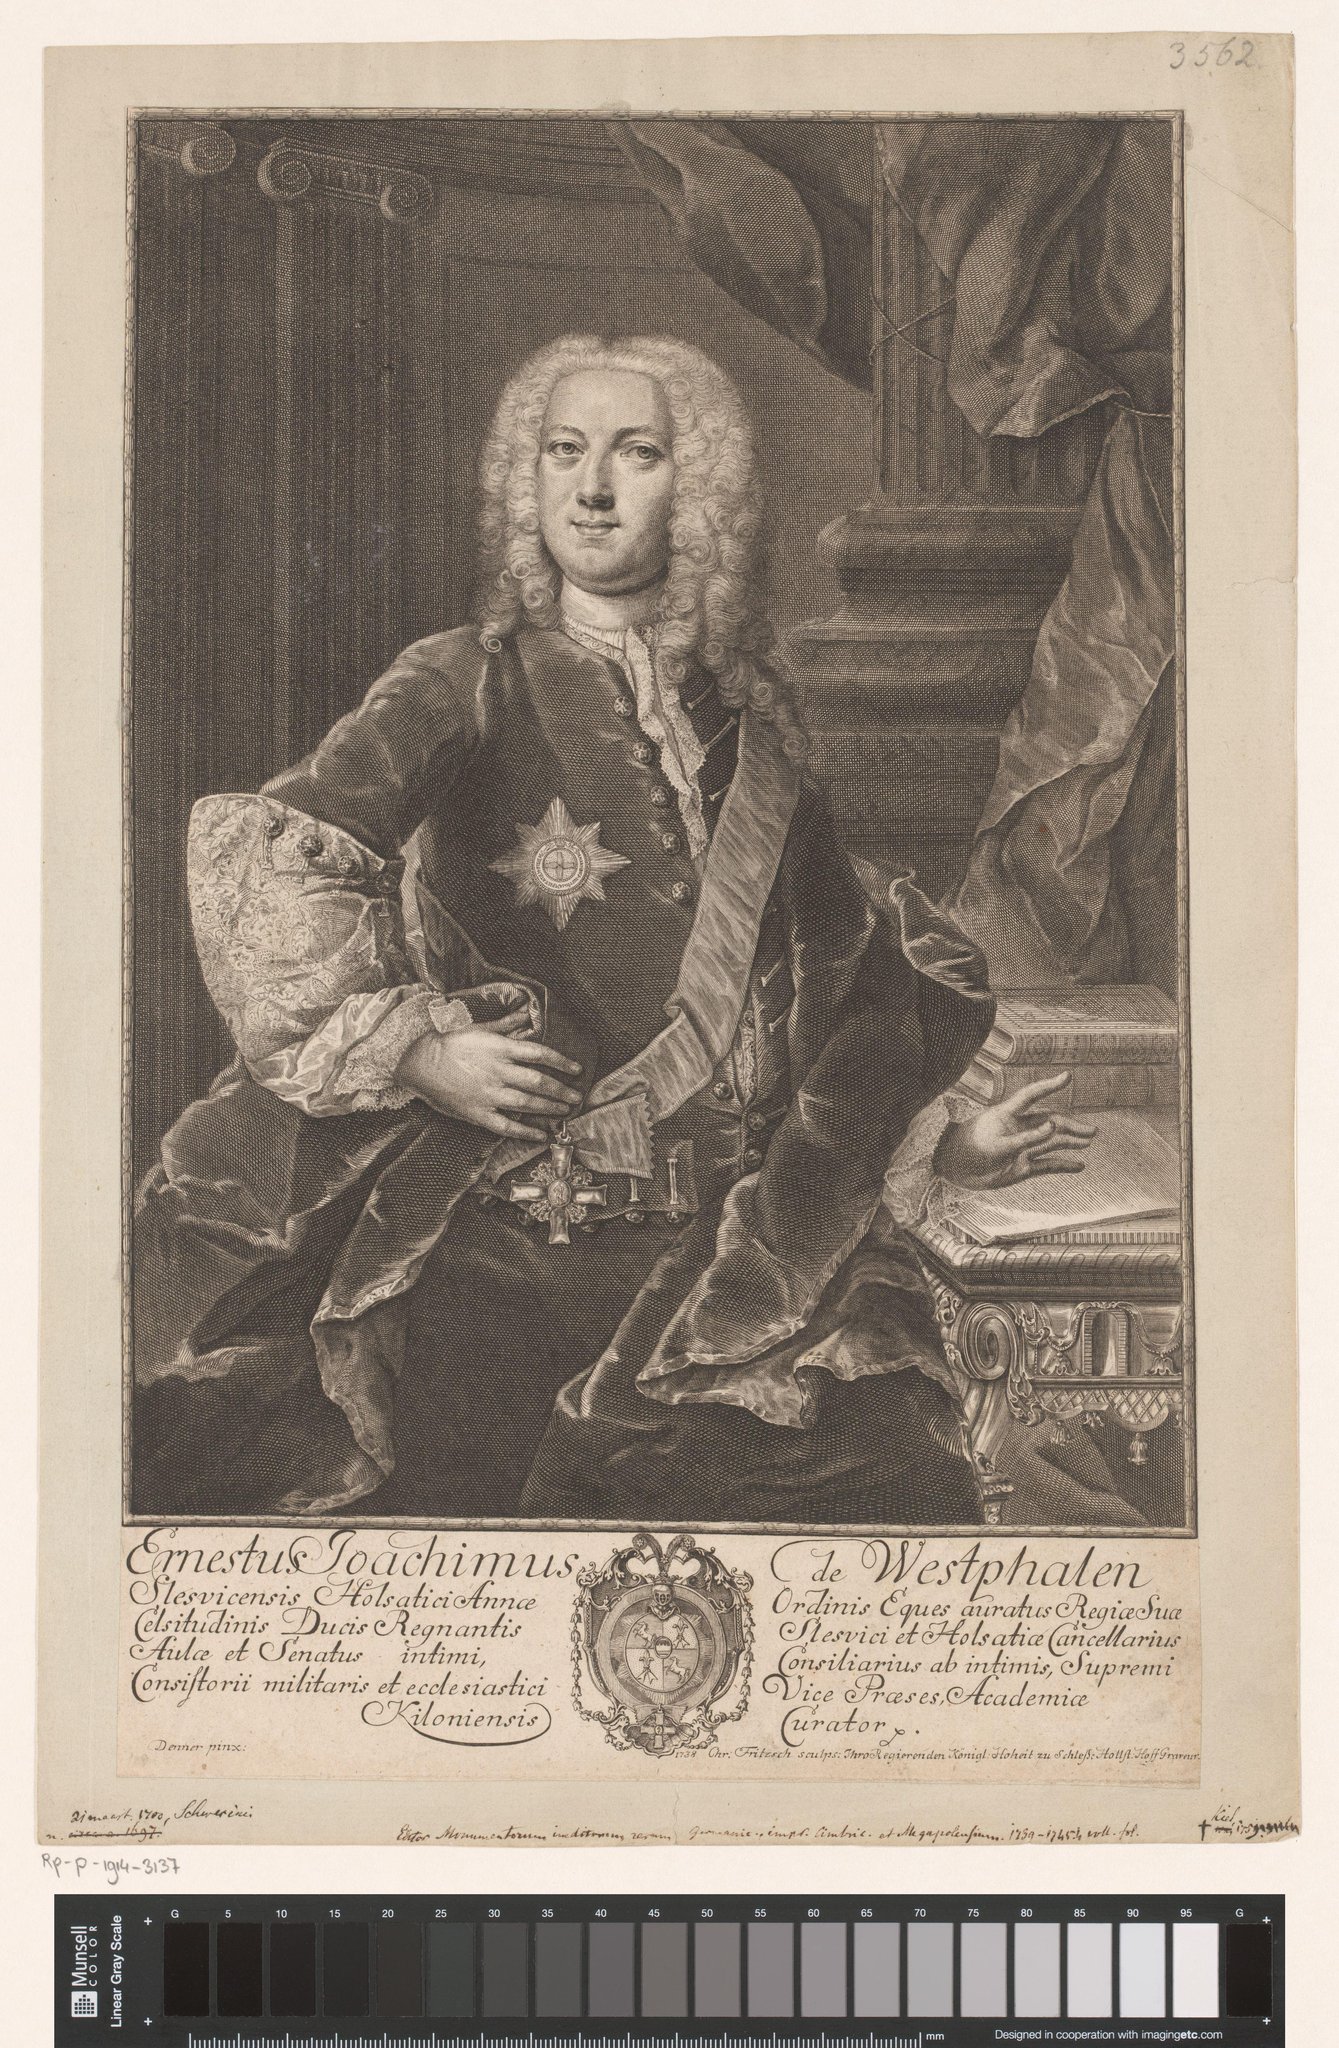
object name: print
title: Portret van Ernst Joachim von Westphalen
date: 1738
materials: paper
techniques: engraving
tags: knighthood order, historical persons, book, medals and other marks of military honour, armorial bearing, heraldry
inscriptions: collector's mark: Lugt 2228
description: Prent gebruikt voor: Westphalen, Ernst Joachim von. Monumenta inedita Rerum Germanicarum praecipue Cimbricarum et Megapolensium (...). Leipzig: Johann Christian Martini, 1739.